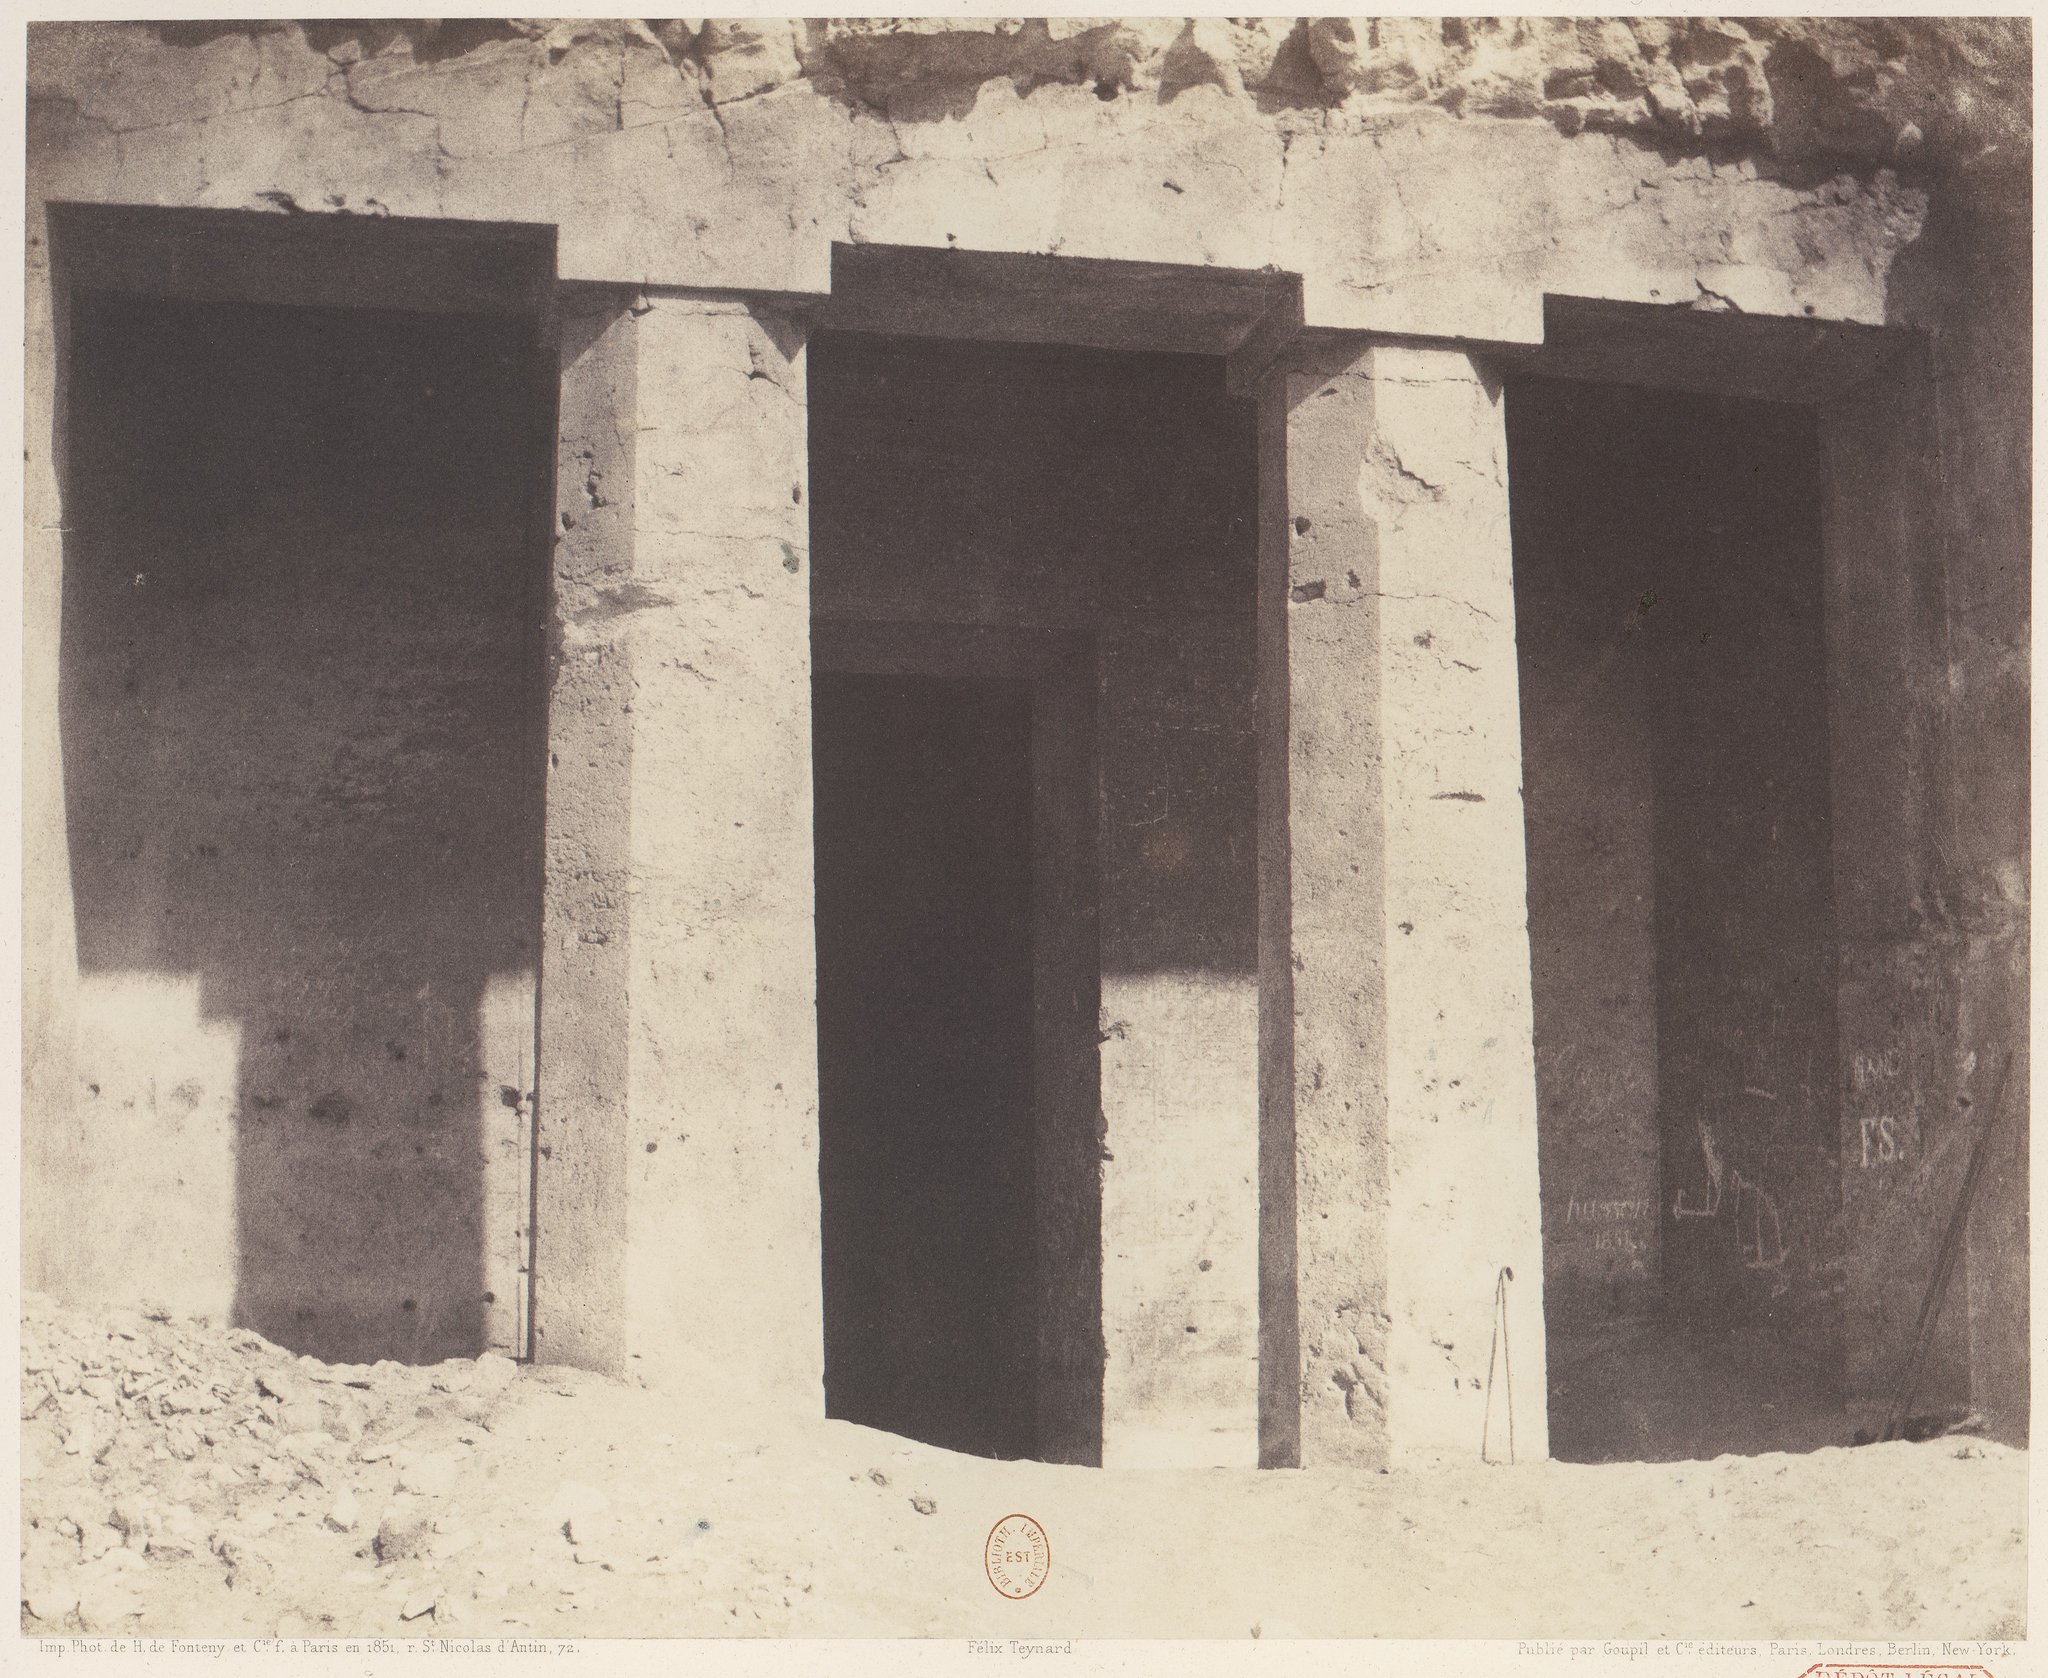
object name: photograph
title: Béni-Haçan, Architecture Hypogéene - Tombeau d'Amoneï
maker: félix teynard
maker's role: artist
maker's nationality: french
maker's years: 1817-1892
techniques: paper negative, salted paper print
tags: architecture,tombs